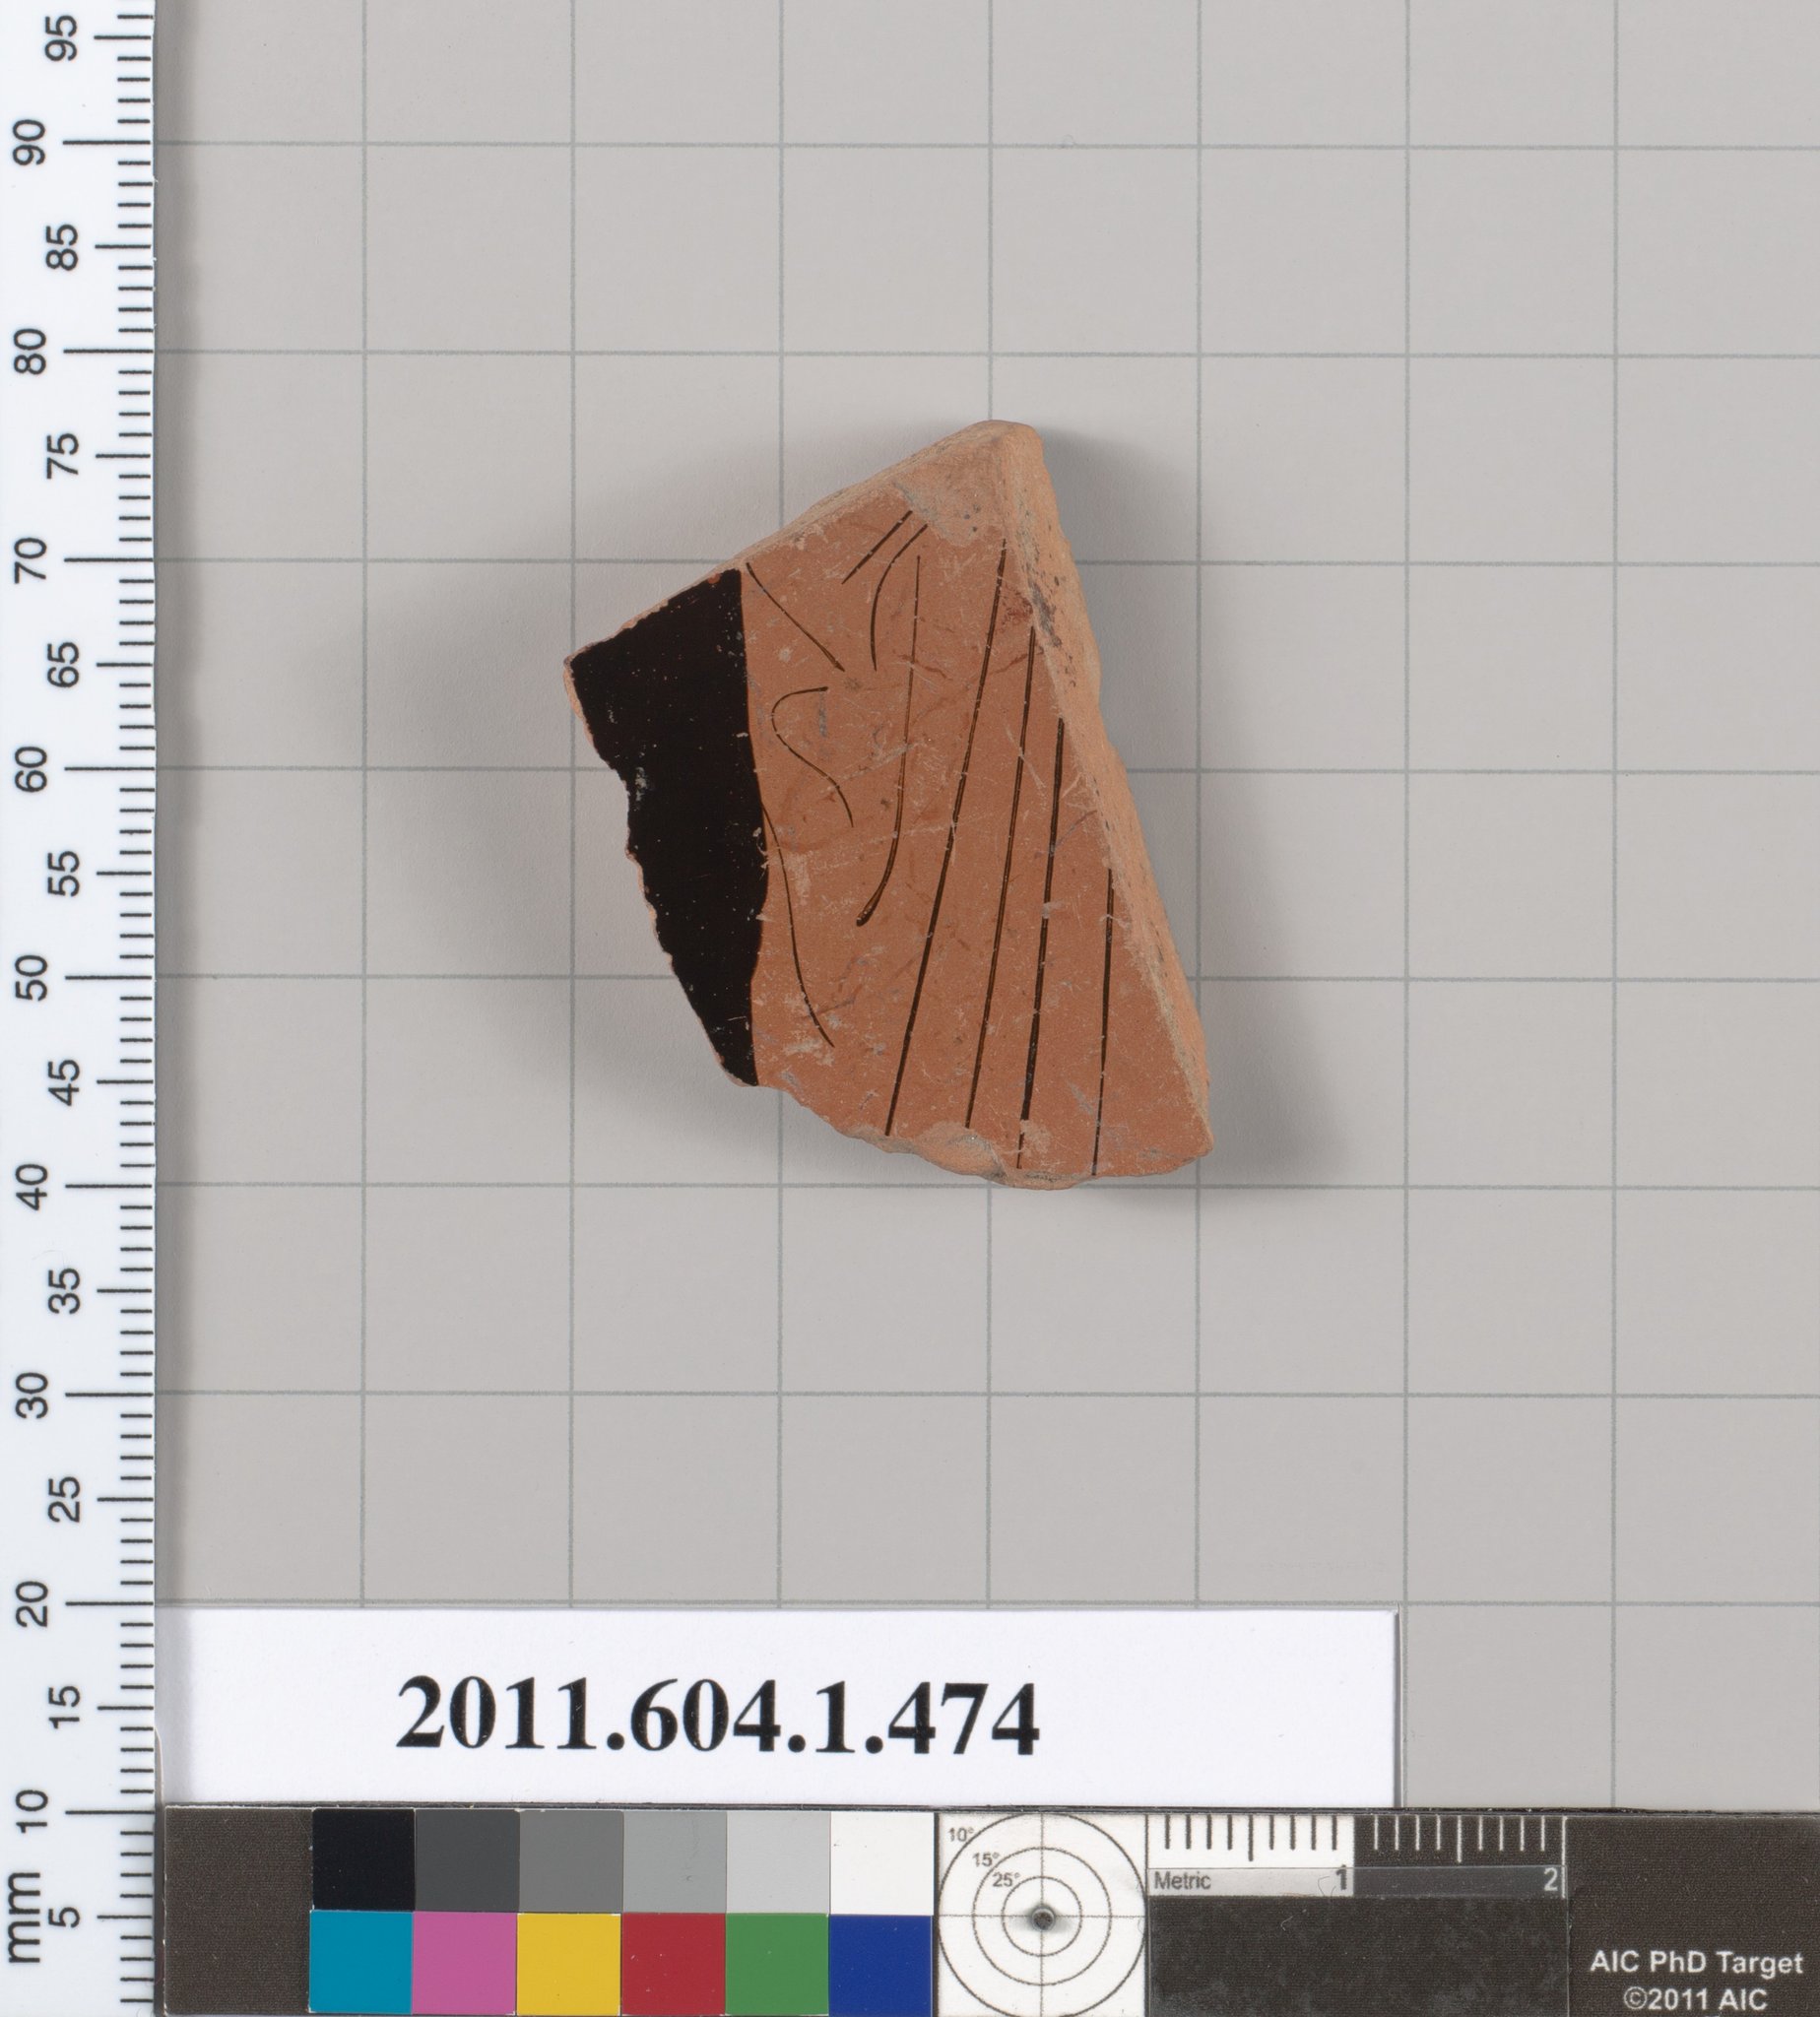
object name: kylix fragment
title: Terracotta fragment of a kylix (drinking cup)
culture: greek, attic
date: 490-480 BCE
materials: terracotta